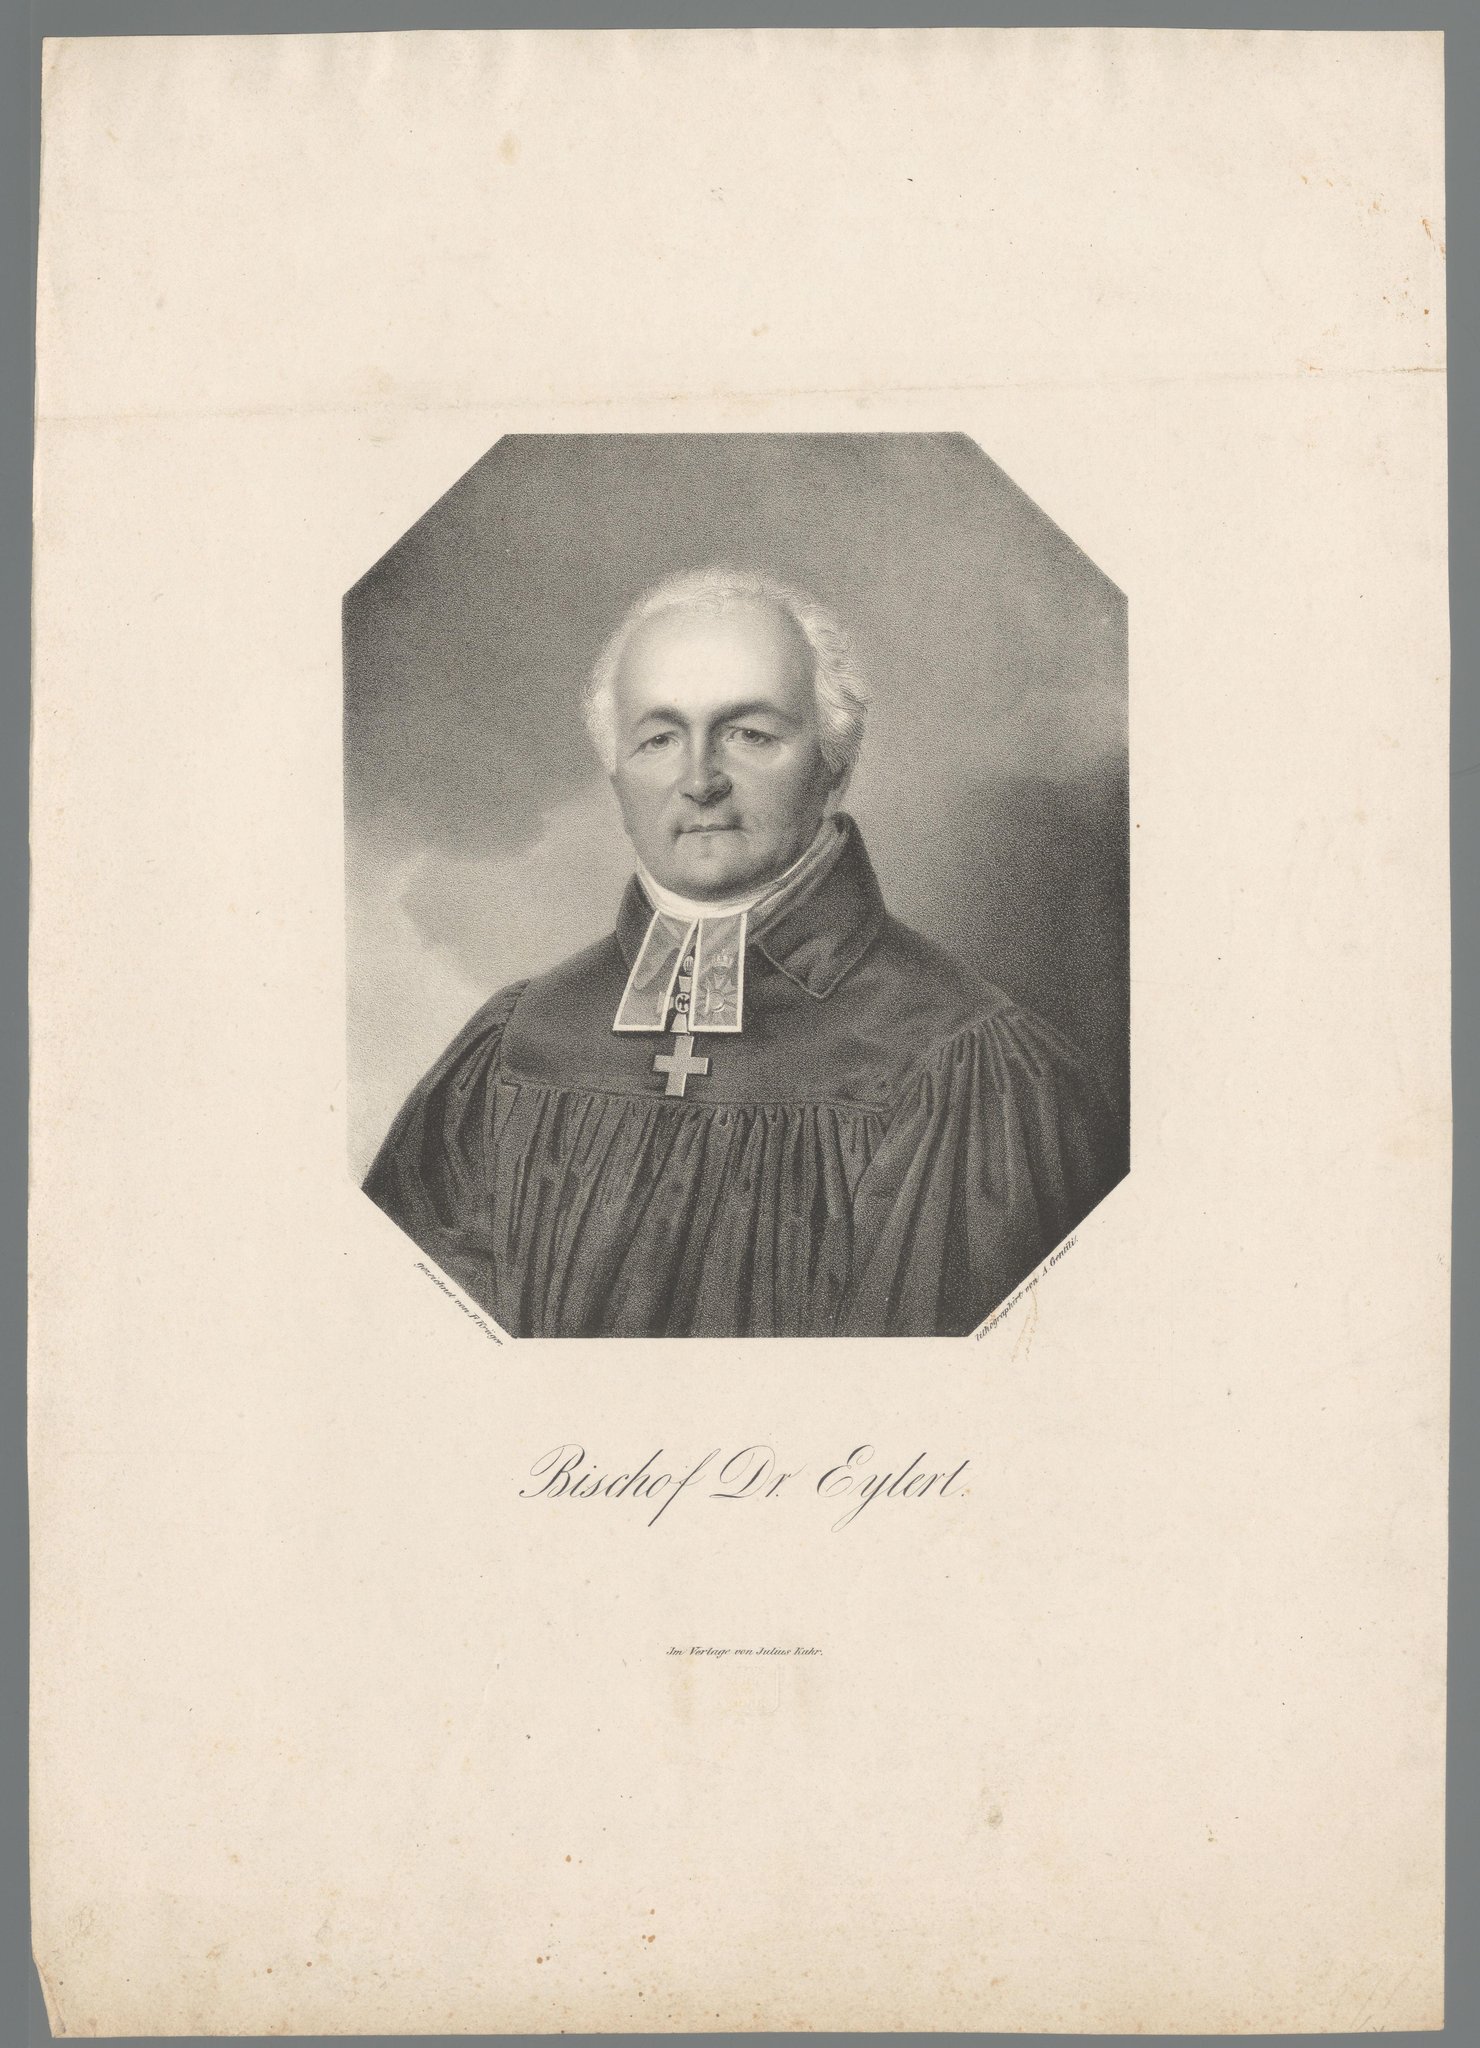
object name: print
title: Bischof Dr. Eylert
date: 1820-1840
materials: paper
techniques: lithograph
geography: berlin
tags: archbishop, bishop, etc. (roman catholic), historical persons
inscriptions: check stamp: ‘Julius Kuhr in Berlin’, collector's mark: Lugt 2228